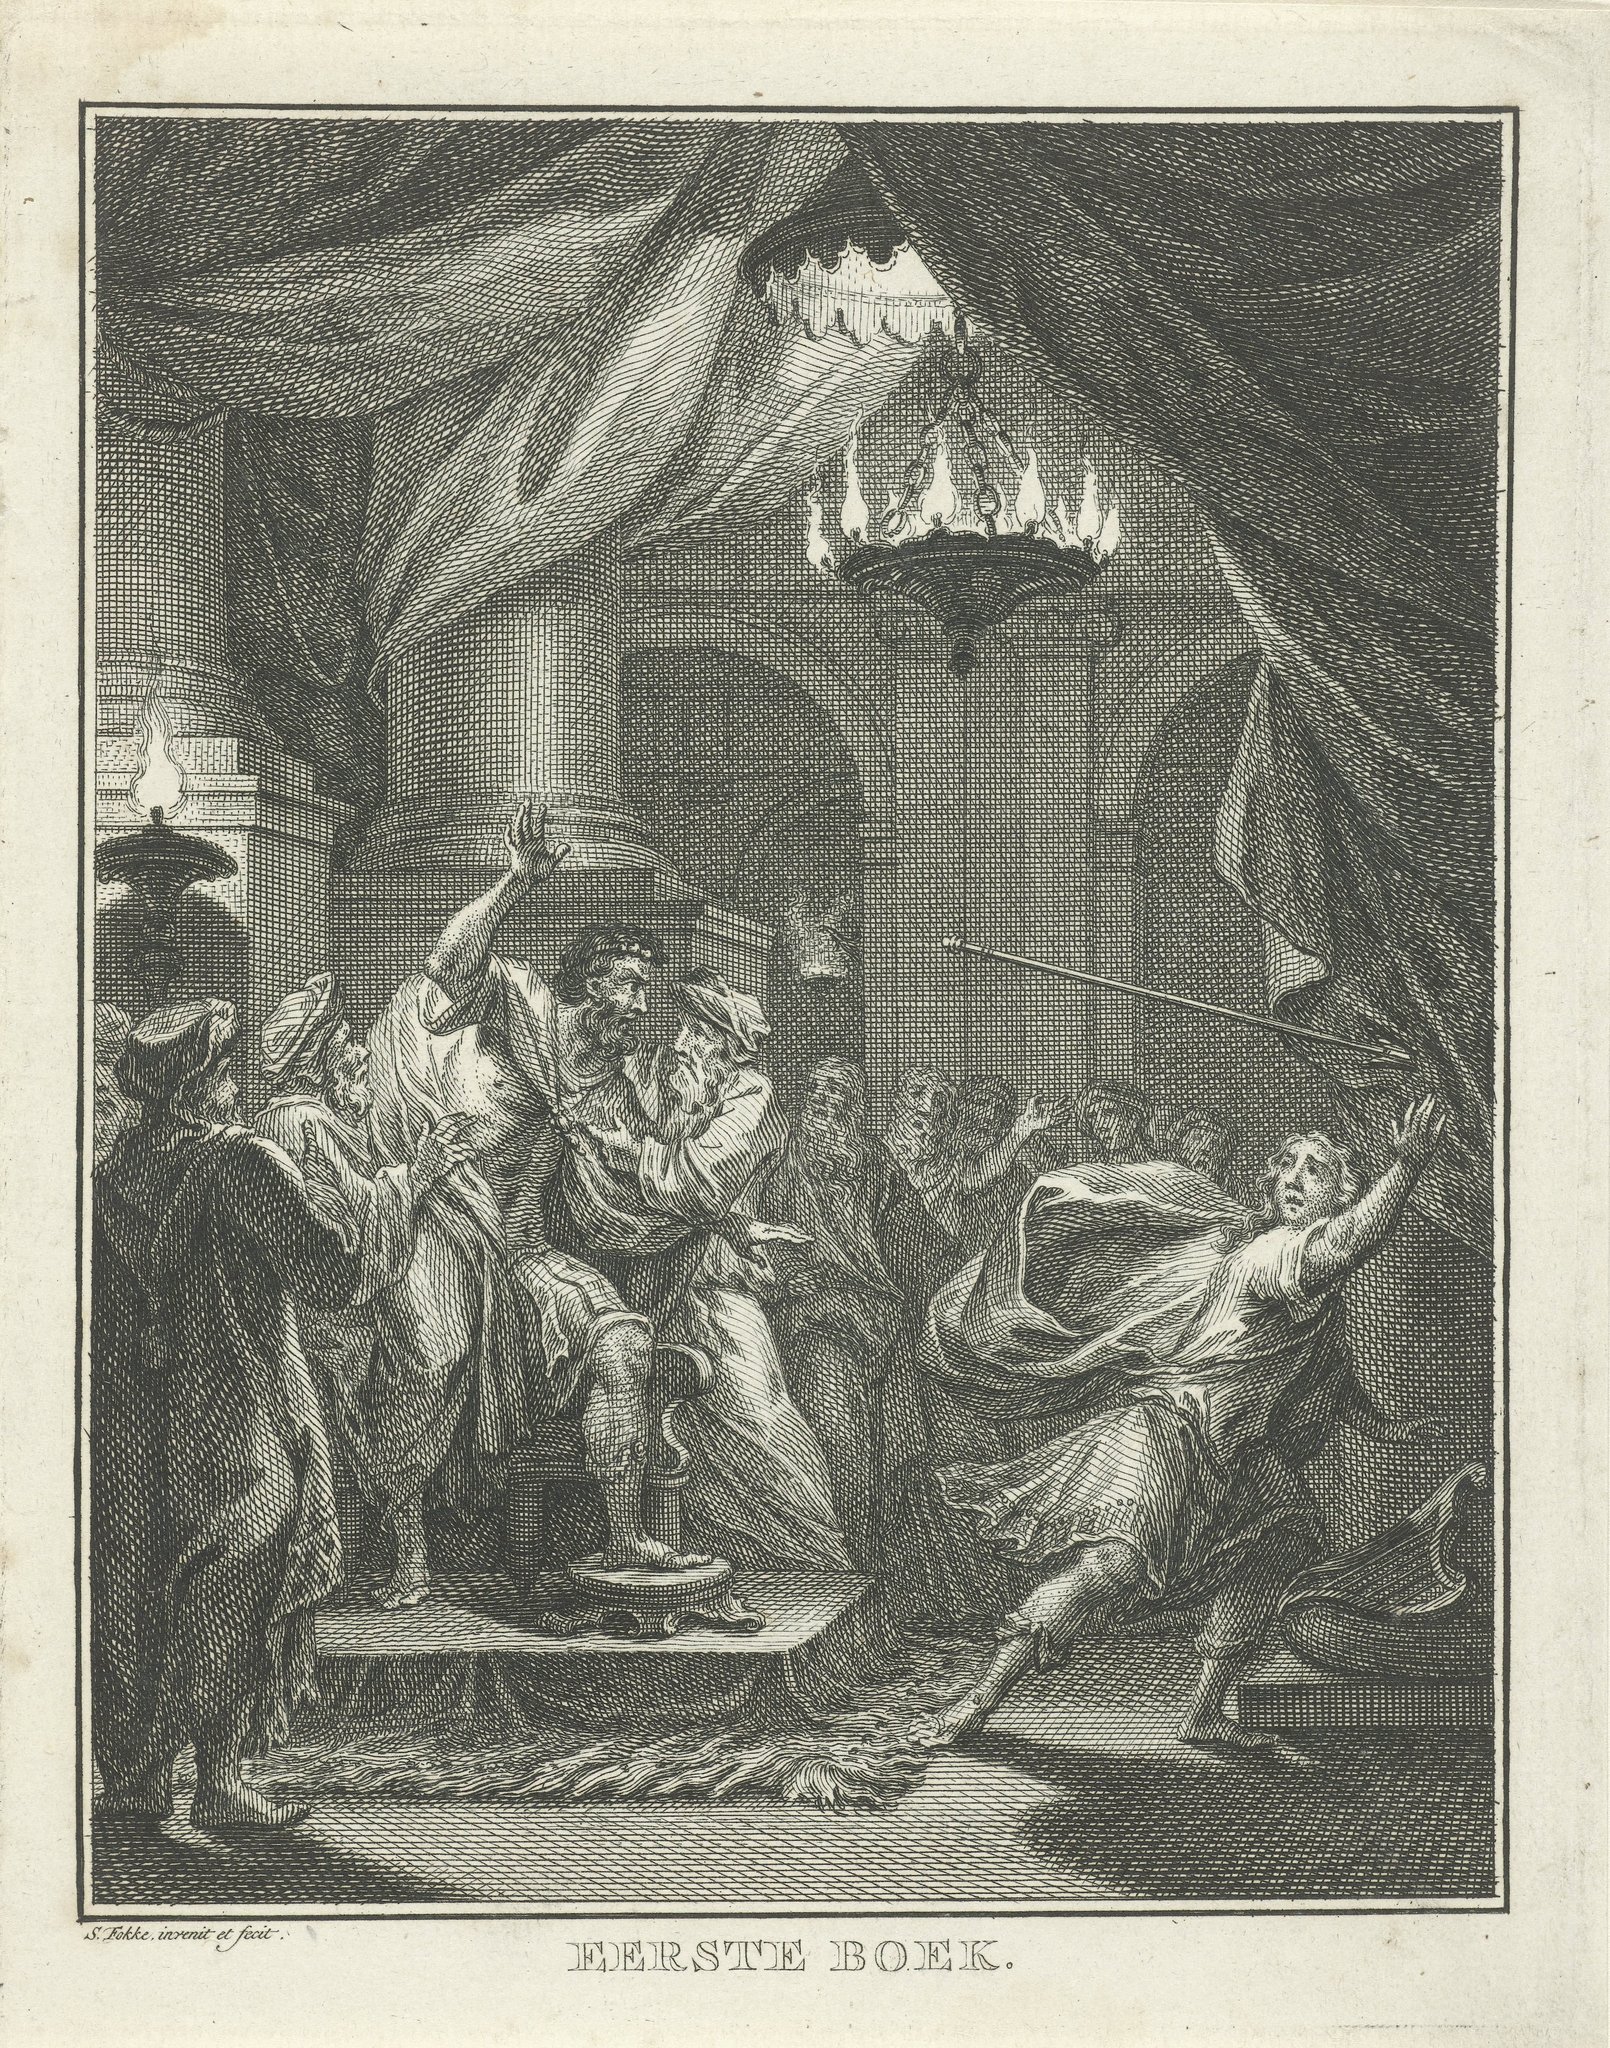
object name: print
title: David en Saul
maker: simon fokke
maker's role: draughtsman, print maker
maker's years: 1712-1784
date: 1766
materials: paper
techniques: etching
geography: amsterdam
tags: saul casts his spear at david when the latter is playing his harp before the king (1 samuel 18:11)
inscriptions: collector's mark: Lugt 2228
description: De jonge David speelt op zijn harp voor de troon van koning Saul. Saul ontsteekt in razernij en probeert met een speer de jongen te doden. Hij wordt tegengehouden door enkele dienaren en soldaten. De prent maakt deel uit van een serie over het verhaal van David en Saul.